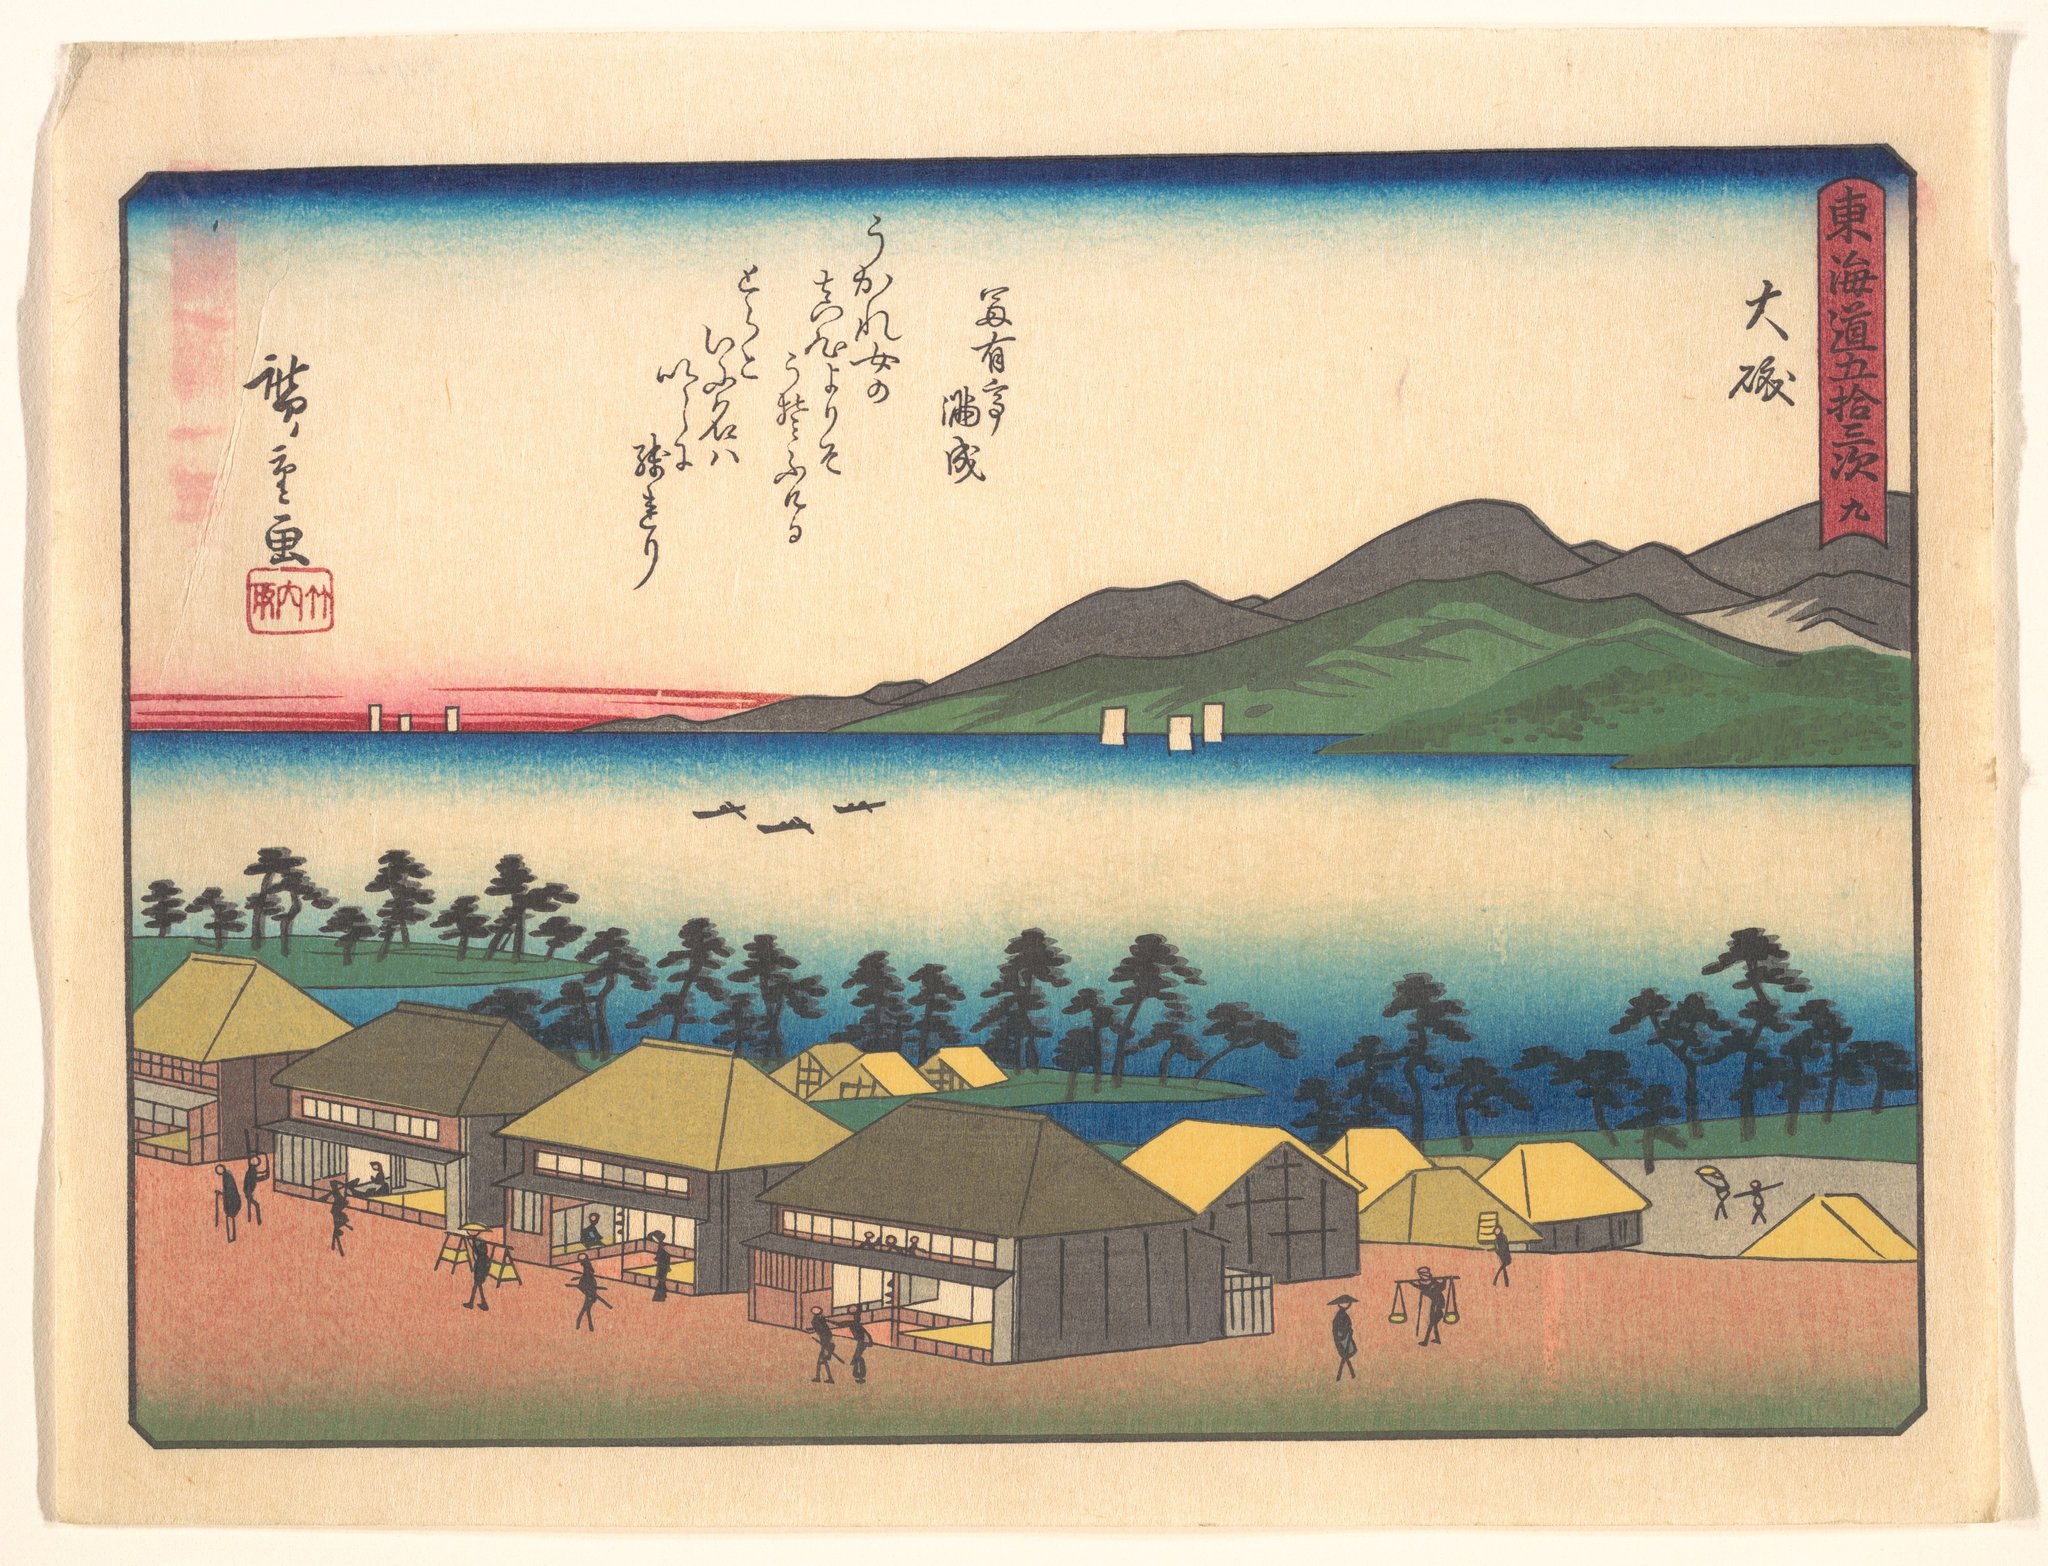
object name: print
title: 東海道五十三次 大磯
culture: japanese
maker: utagawa hiroshige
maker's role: artist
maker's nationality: japanese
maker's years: 1797-1858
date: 1901-1933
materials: ink, paper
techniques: woodblock print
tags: rivers,mountains,landscapes